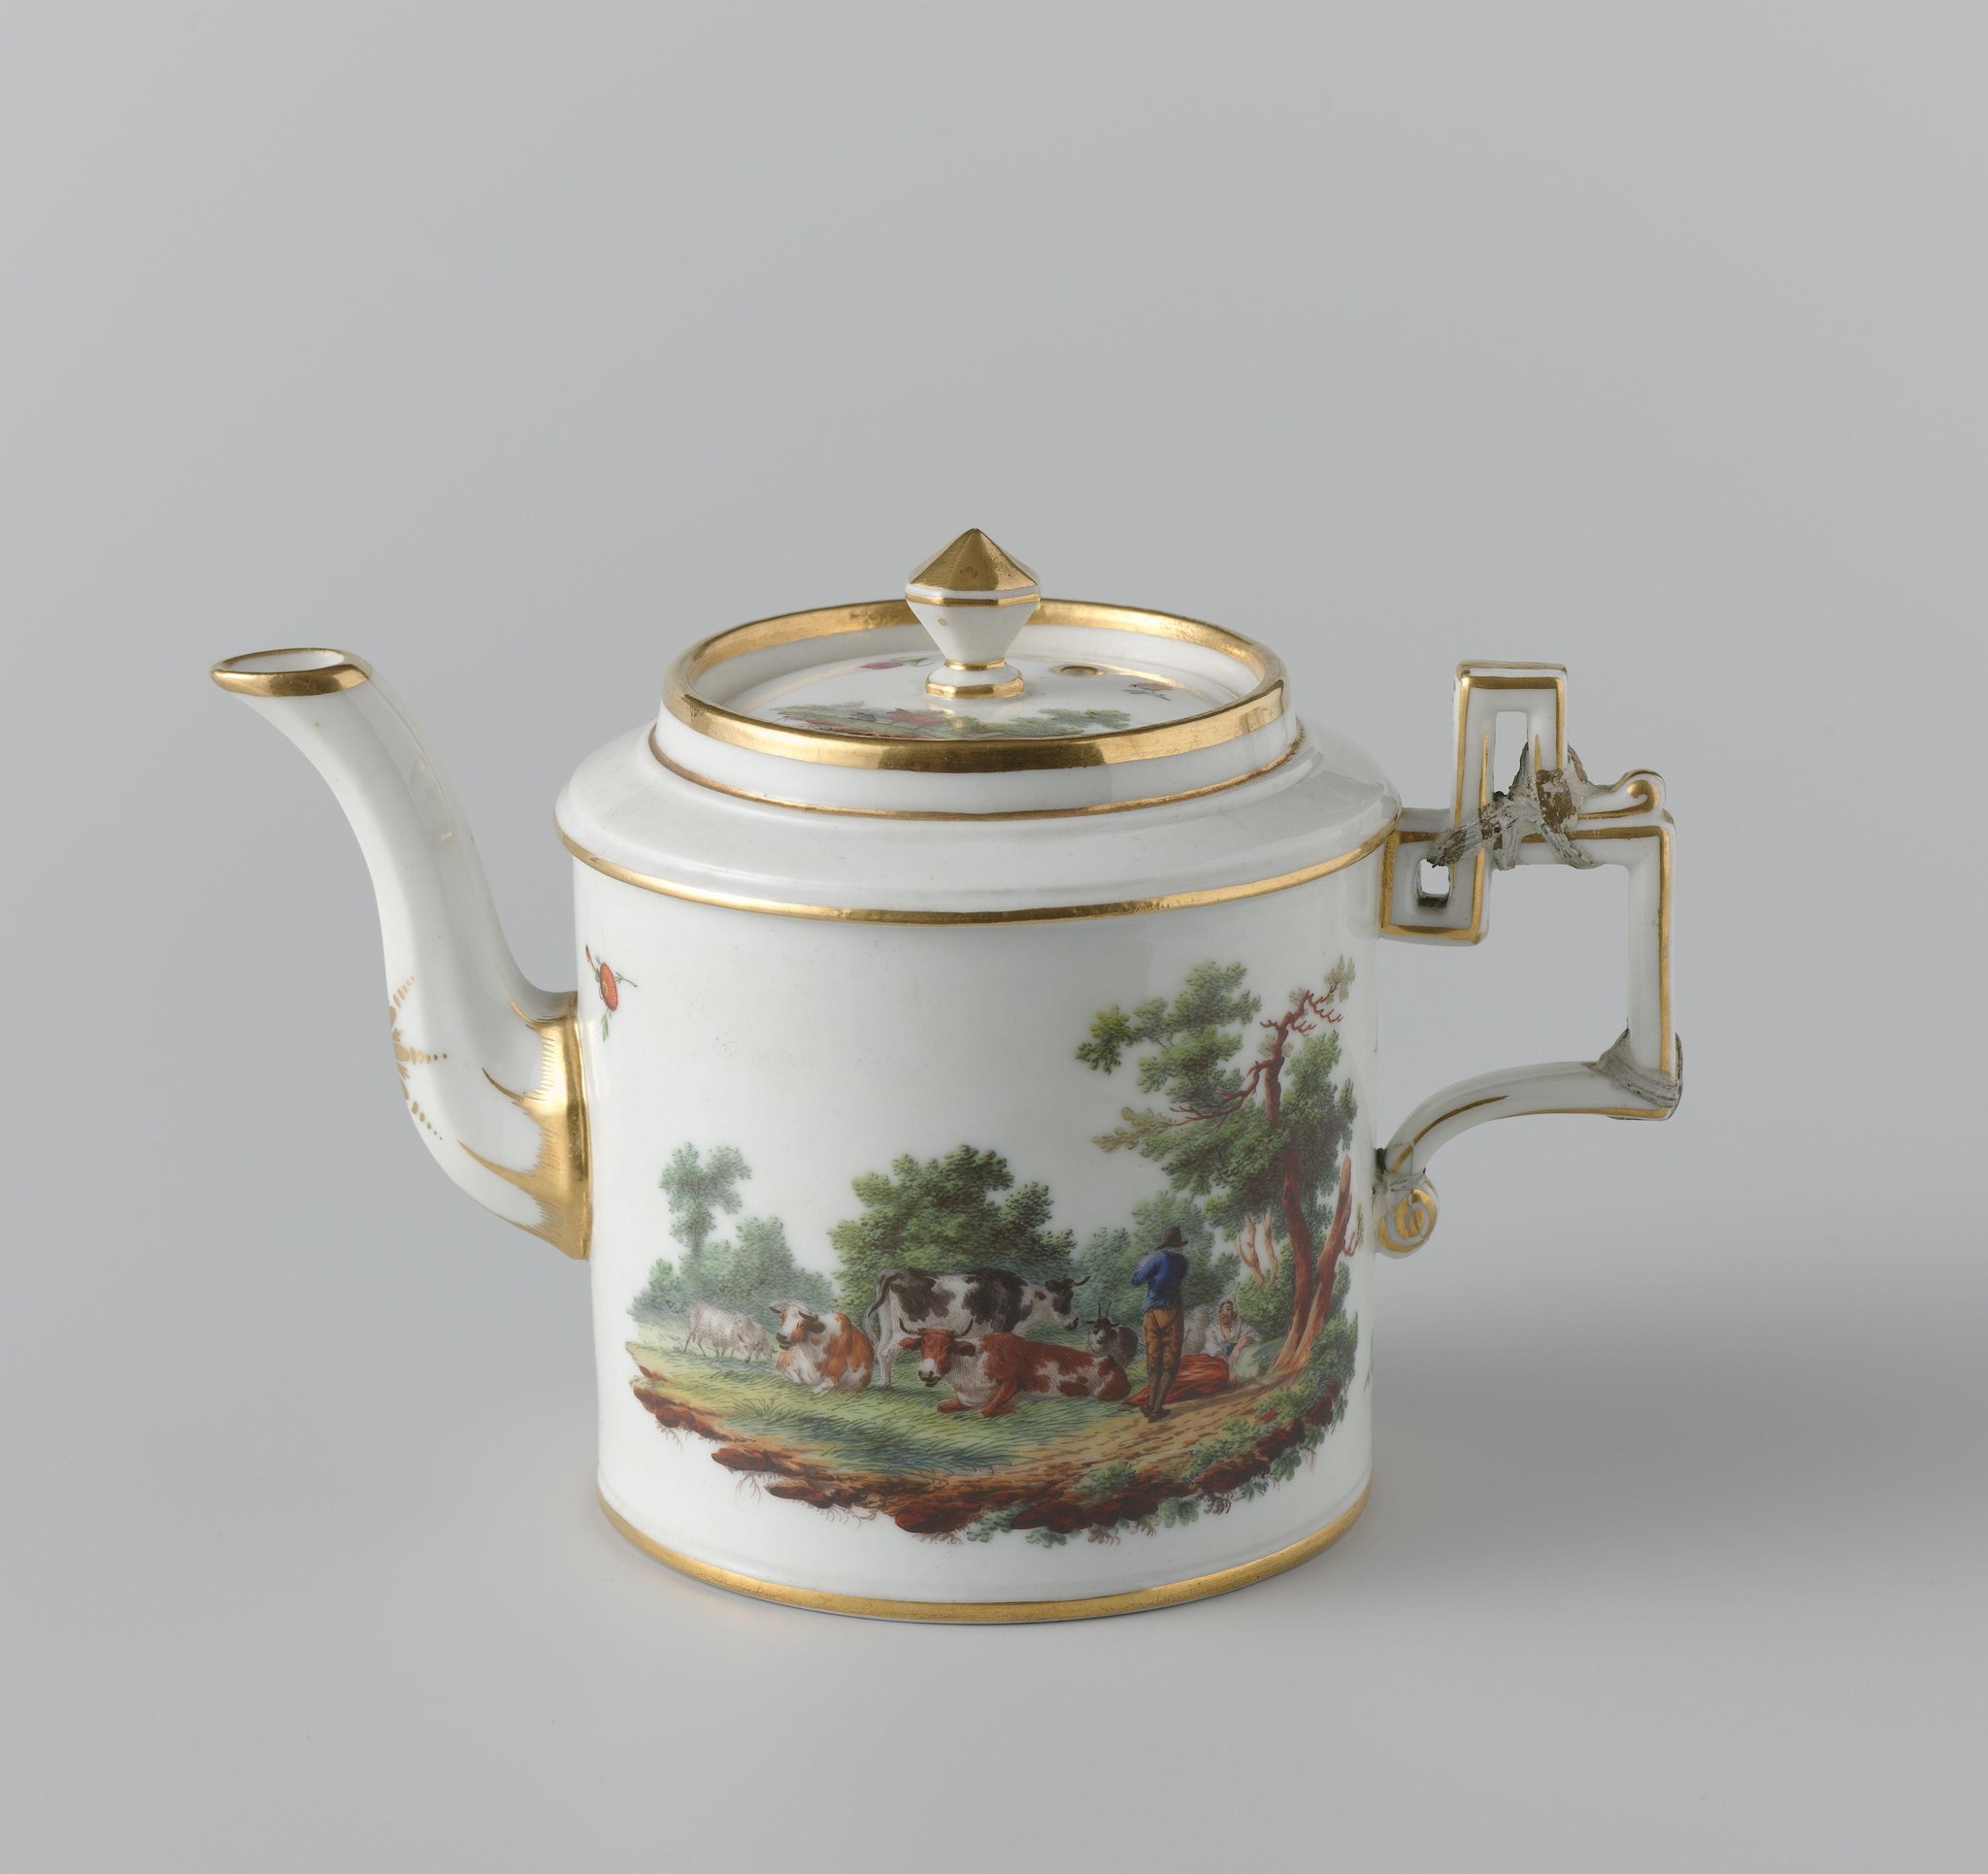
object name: lid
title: Deksel vantTheepot, beschilderd met een landschap met vee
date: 1809-1814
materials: porcelain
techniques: painted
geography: nieuwer-amstel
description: Deksel van theepot beschilderd met landschap met vee.